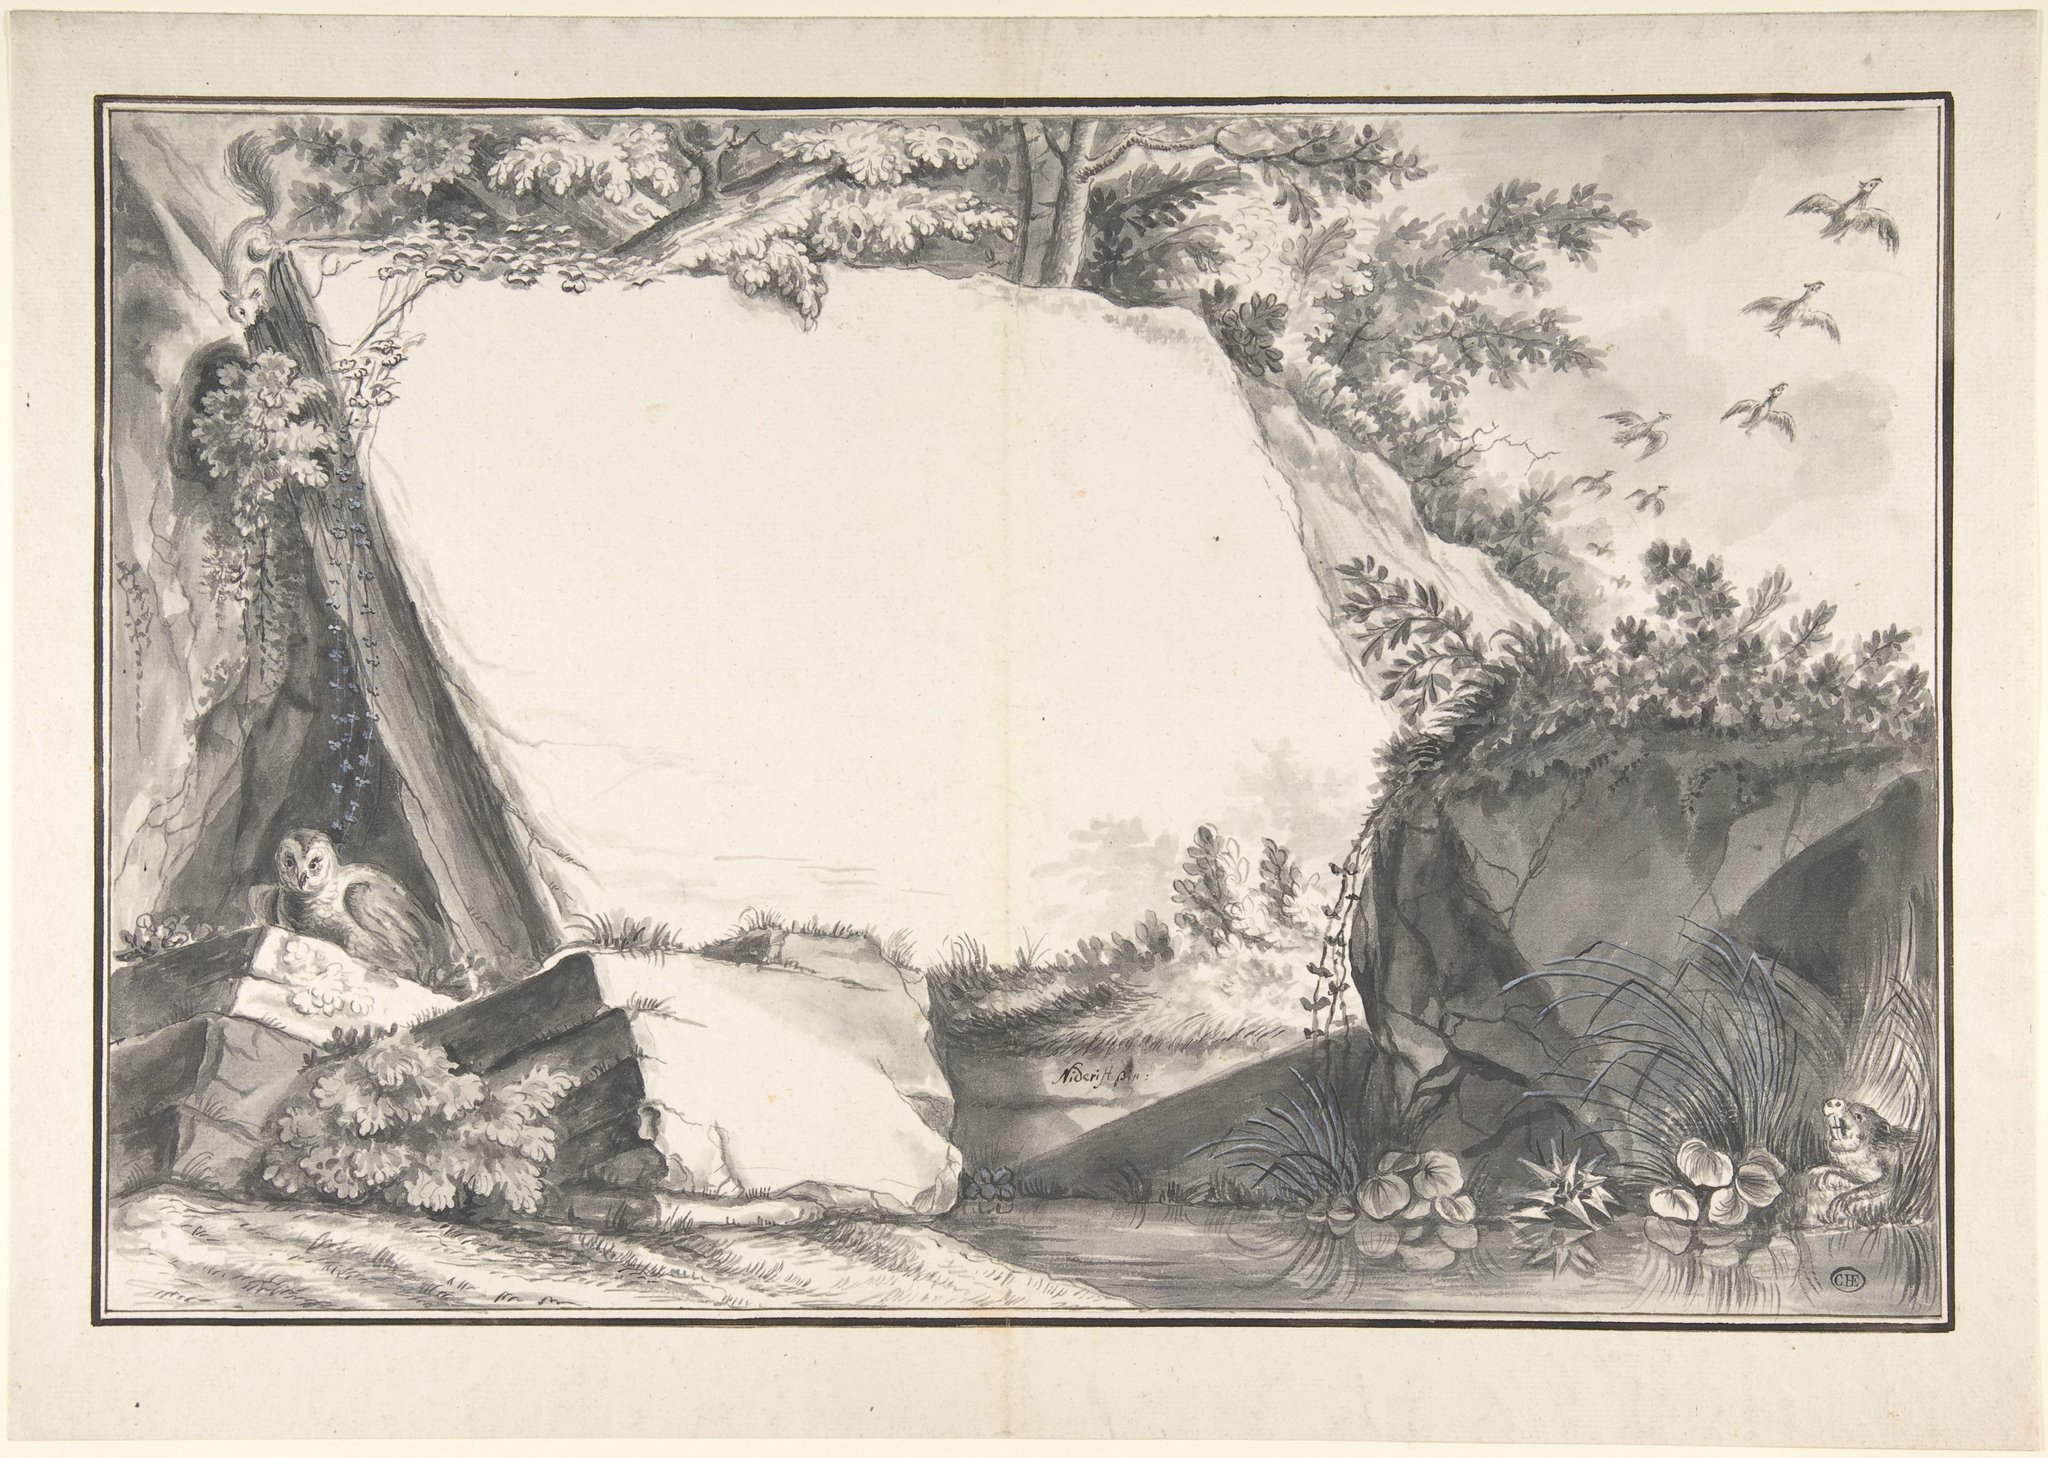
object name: drawing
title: Design for a Title Page(?): Rocks and Animals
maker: joseph martin nideröst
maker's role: artist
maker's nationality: swiss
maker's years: 1778-1801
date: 1767-1800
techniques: brush, heightening, wash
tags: birds,owls,trees